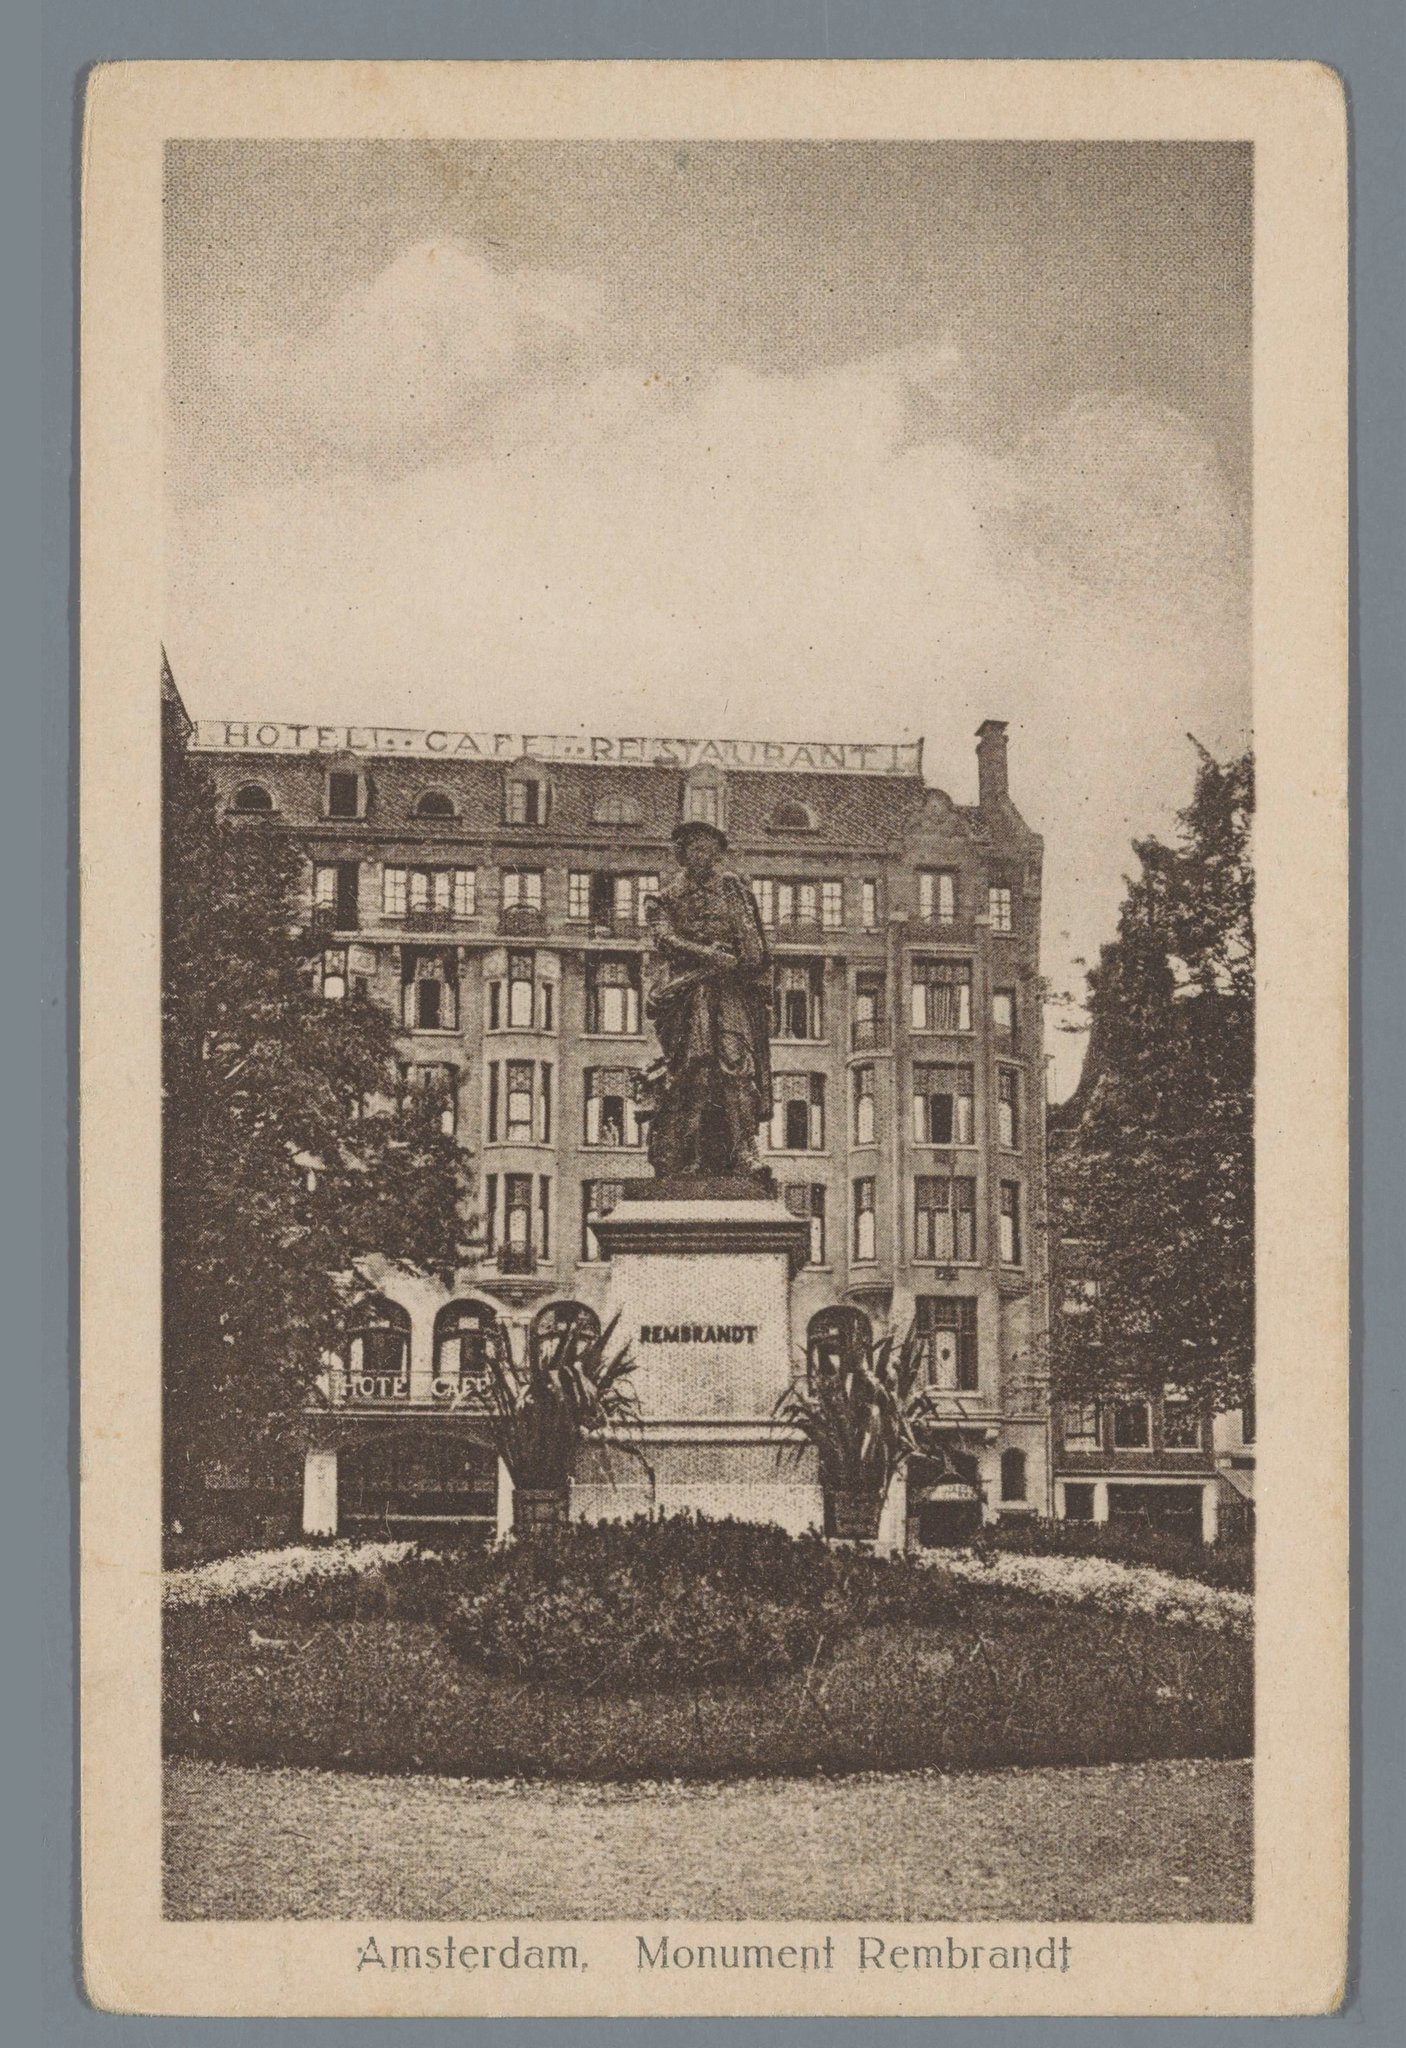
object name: photomechanical print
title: Amsterdam, Monument Rembrandt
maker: paa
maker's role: fotograaf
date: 1875-1930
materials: cardboard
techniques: photograph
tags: leiden, amsterdam, painter, print maker, draughtsman, rembrandt van rijn, monument, statue